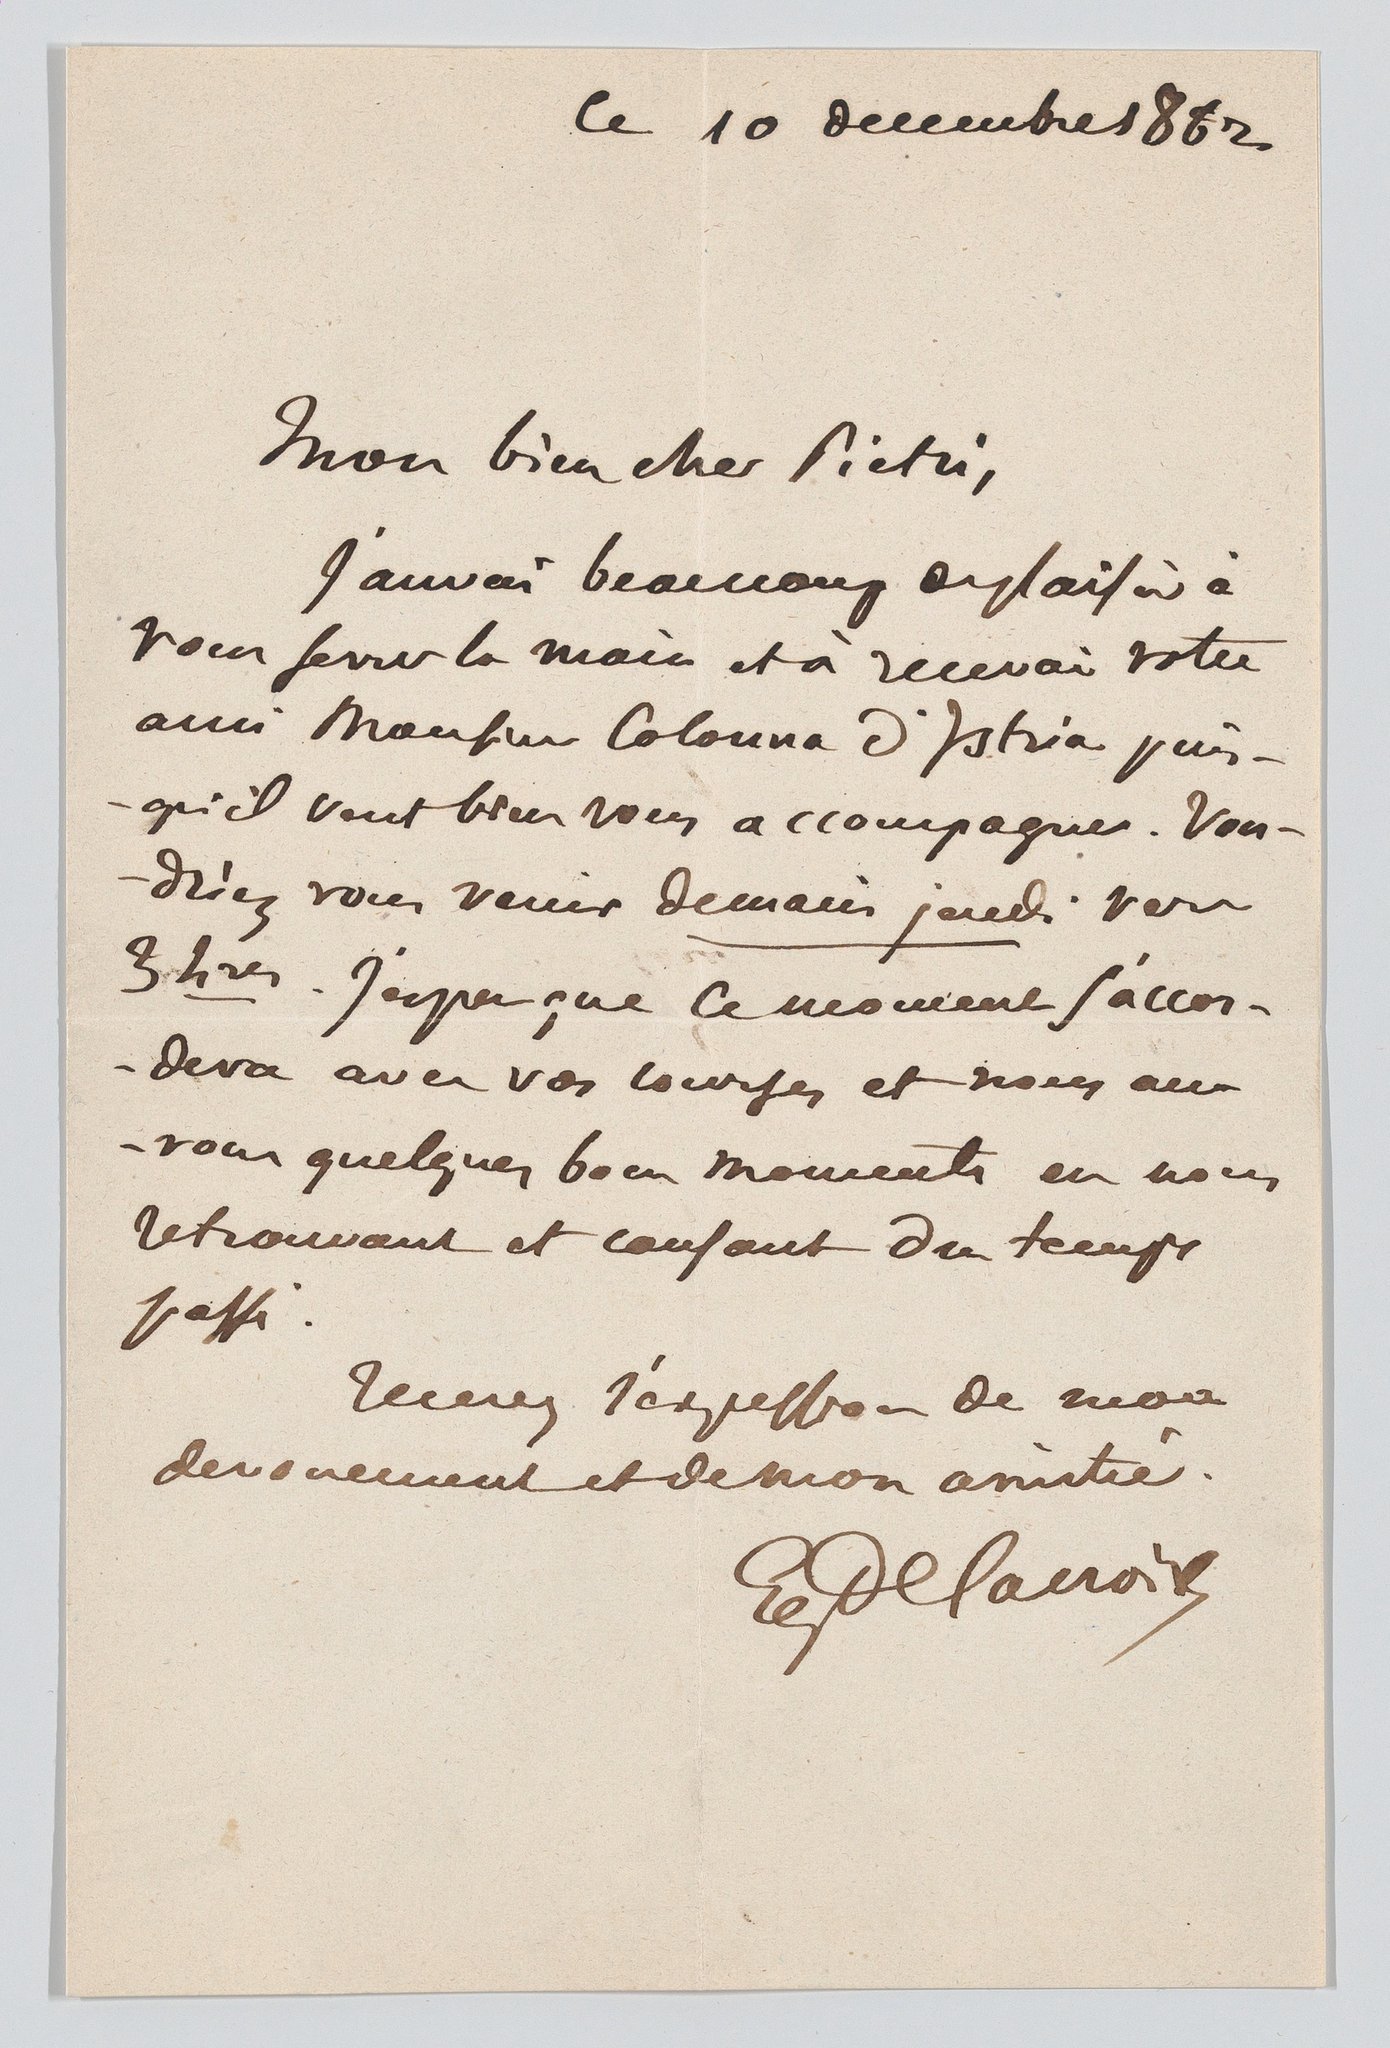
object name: drawing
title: Letter to Pierre Marie Pietri, with envelope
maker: eugène delacroix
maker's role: artist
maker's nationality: french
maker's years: 1798-1863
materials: ink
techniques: pen